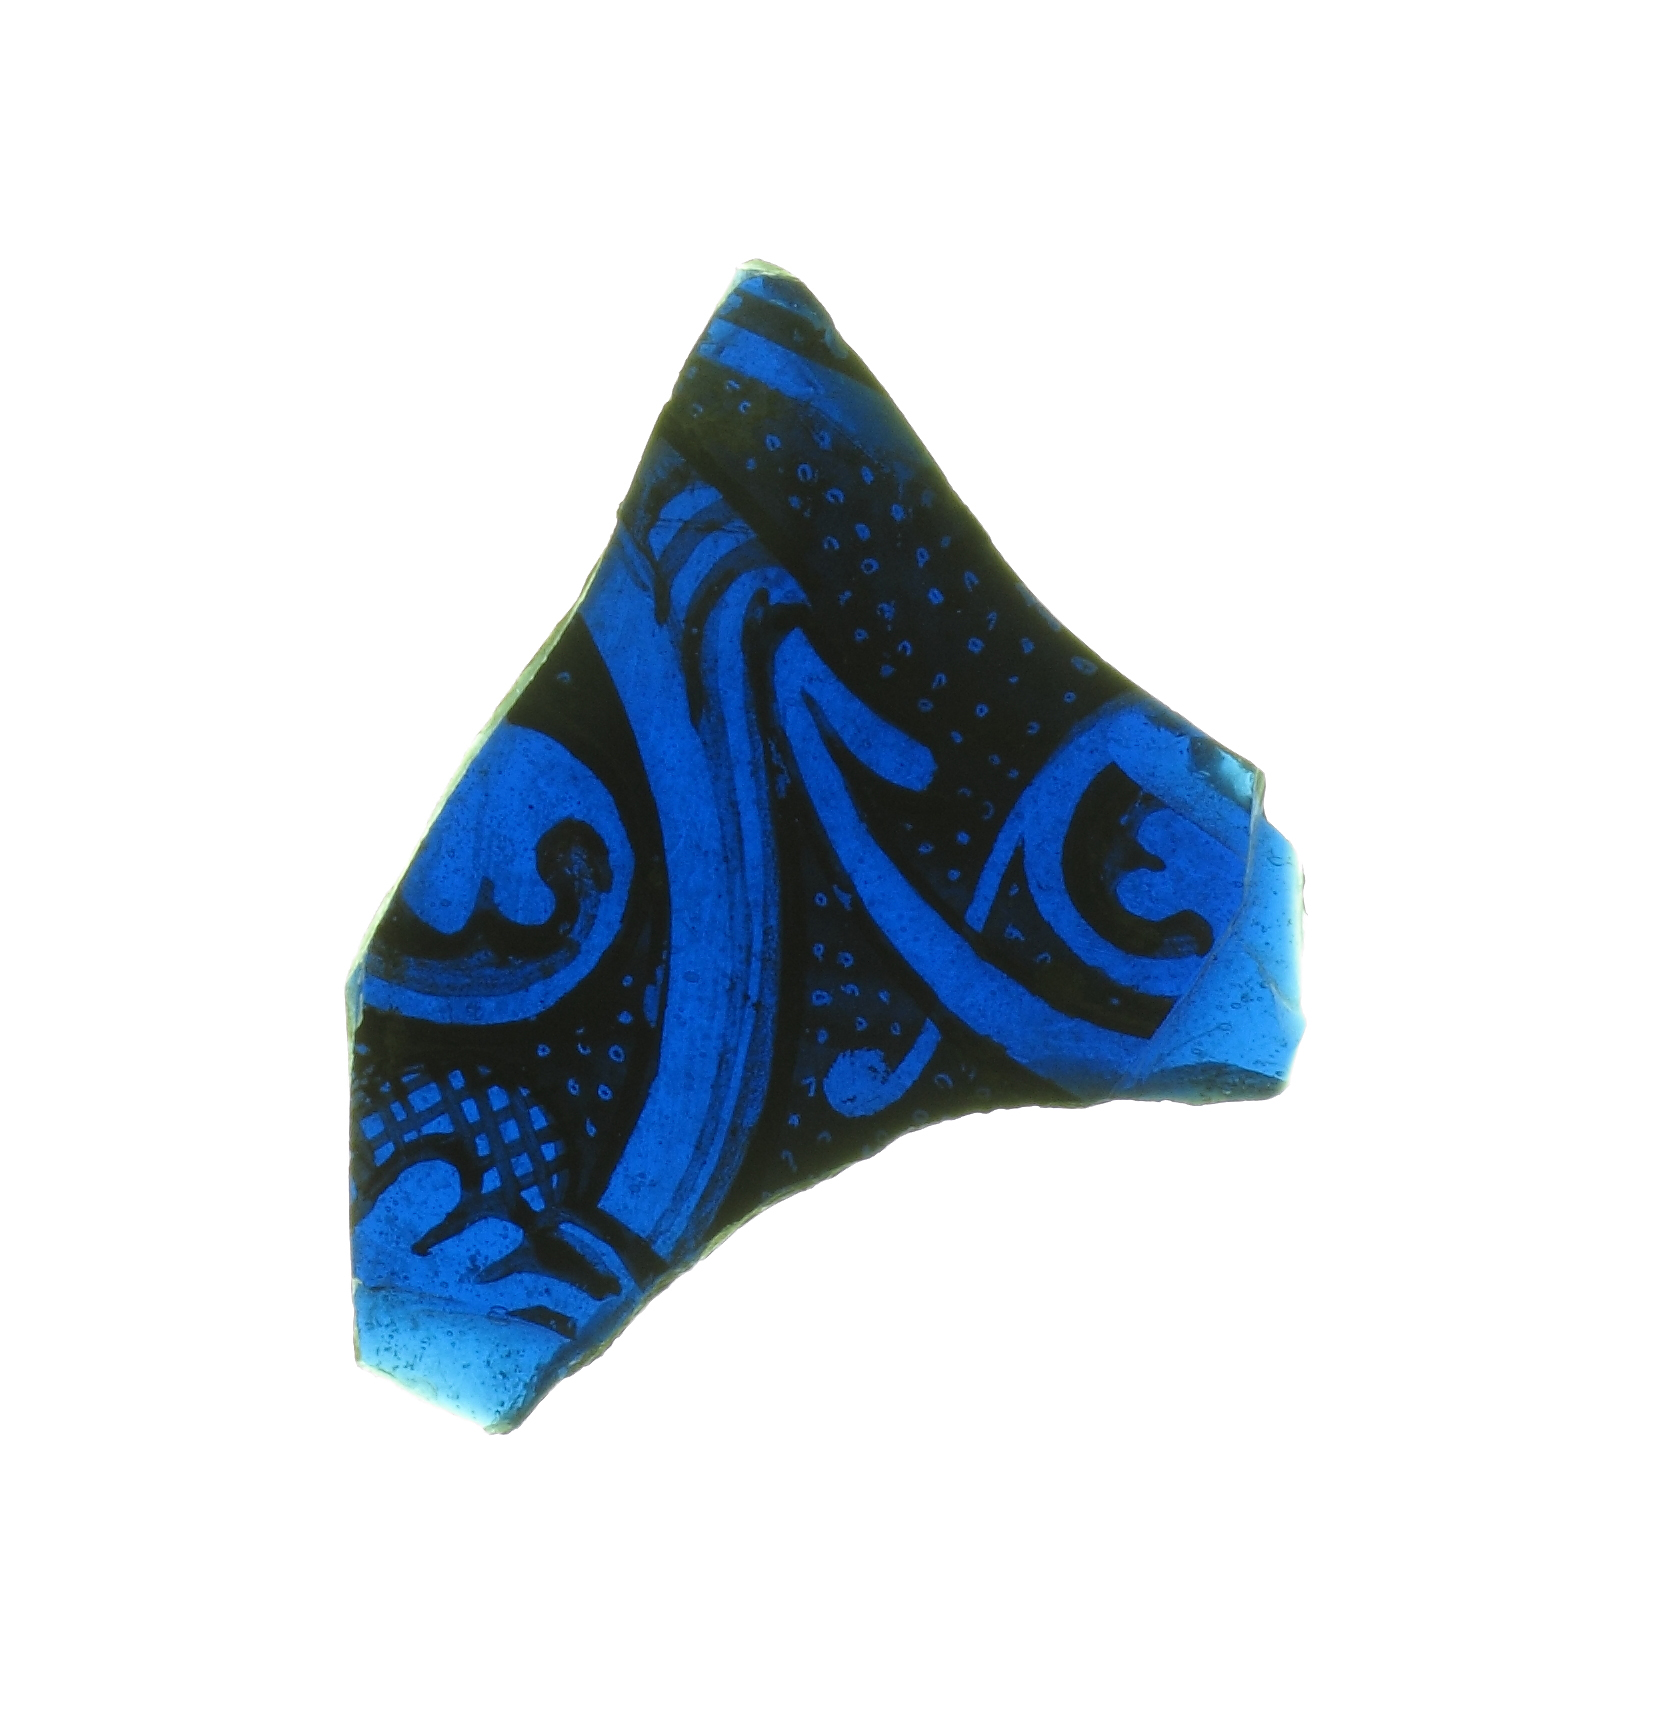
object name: fragment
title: Glass Fragment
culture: french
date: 1101-1400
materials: glass, metal, paint